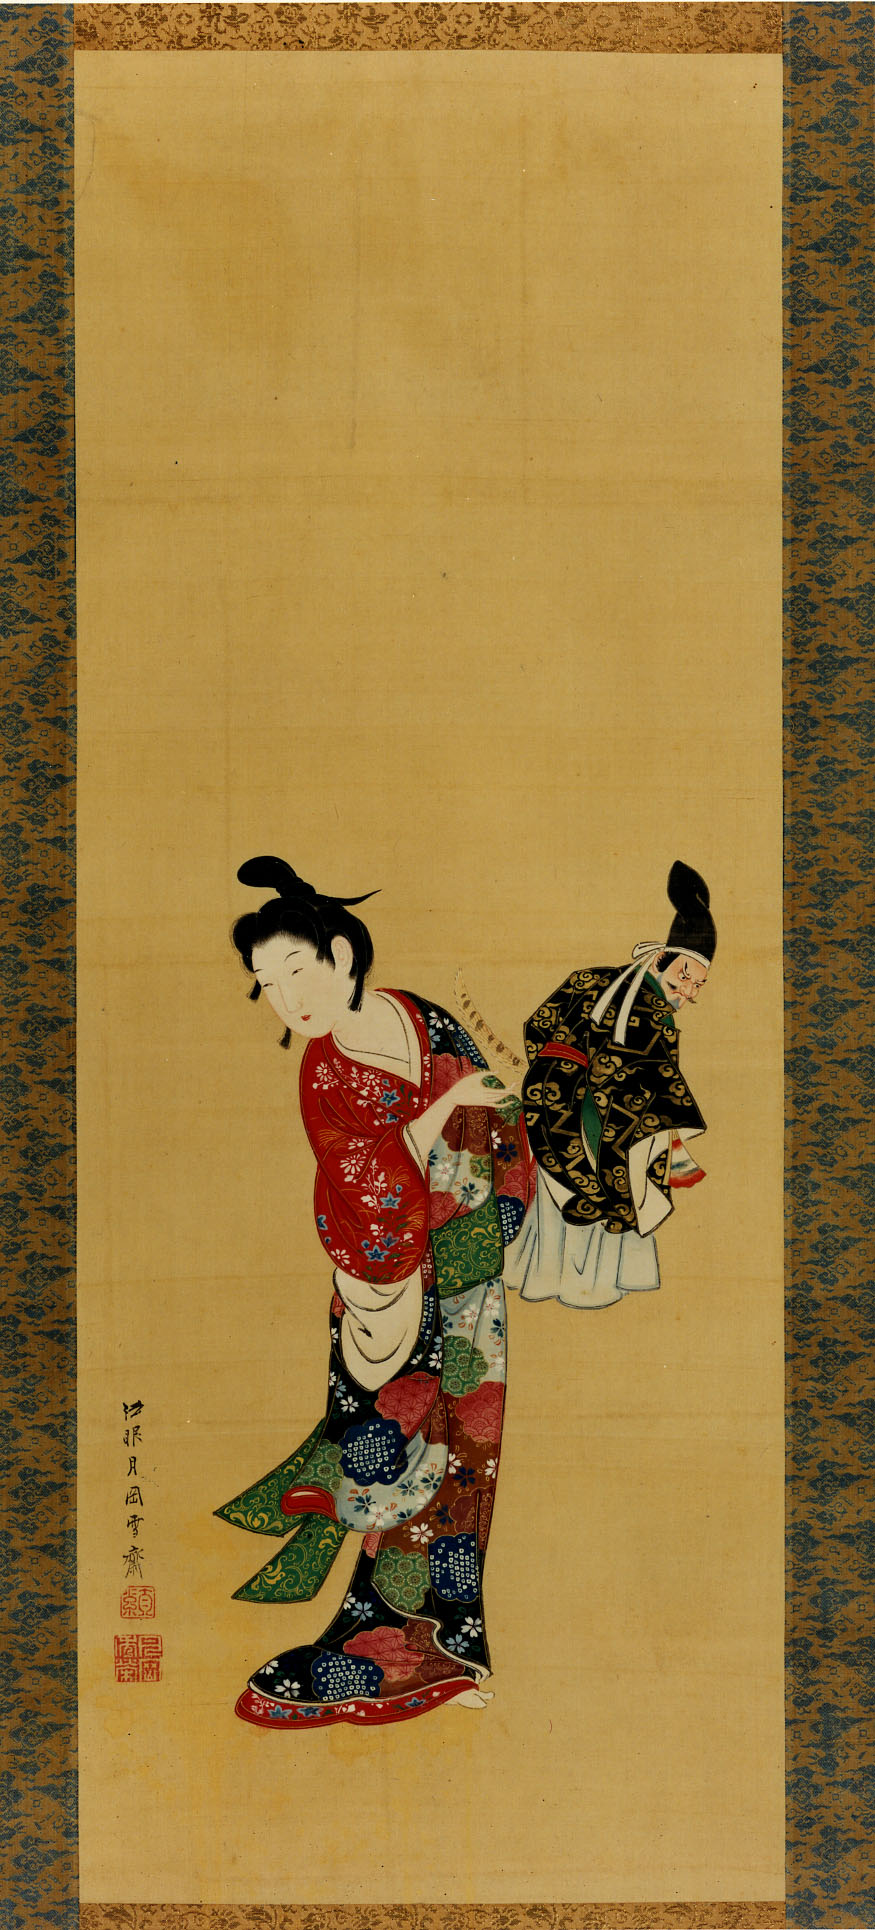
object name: hanging scroll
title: Puppeteer with Puppet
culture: japanese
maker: tsukioka sessai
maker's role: artist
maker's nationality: japanese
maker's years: 1761-1839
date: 1761-1839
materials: ink, silk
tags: men,women,puppets